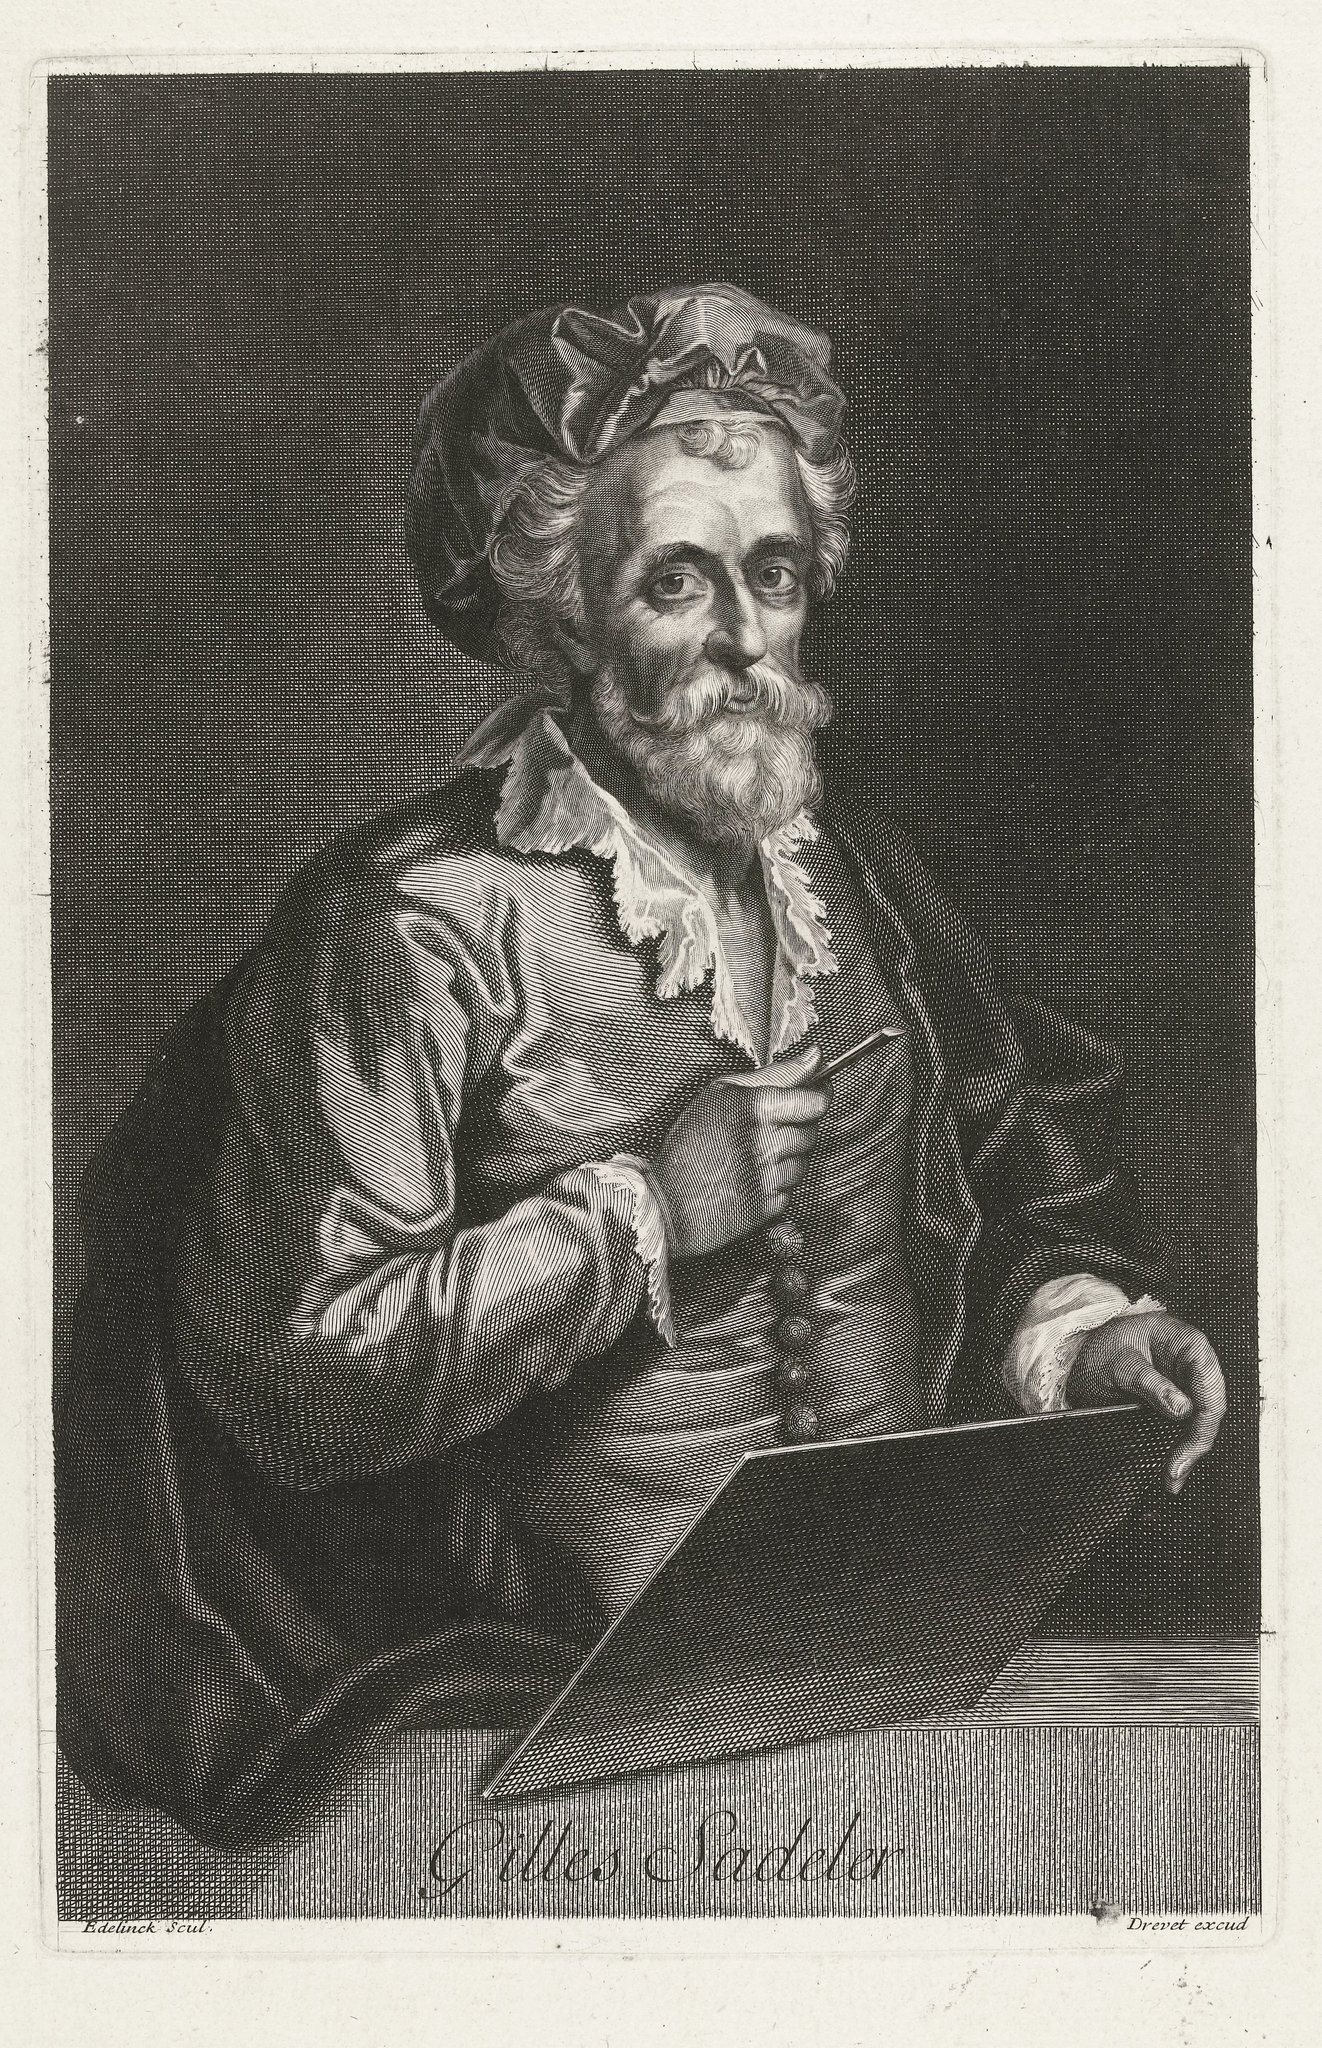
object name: print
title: Gilles Sadeler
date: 1673-1707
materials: paper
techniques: engraving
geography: france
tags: antwerp, prague, draughtsman, aegidius sadeler (ii)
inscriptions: collector's mark: Lugt 240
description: Portret van de prentkunstenaar Aegidius (Gilles) Sadeler (1570-1629), ten halven lijve afgebeeld met burijn in rechter en loodplaat in rechter hand.